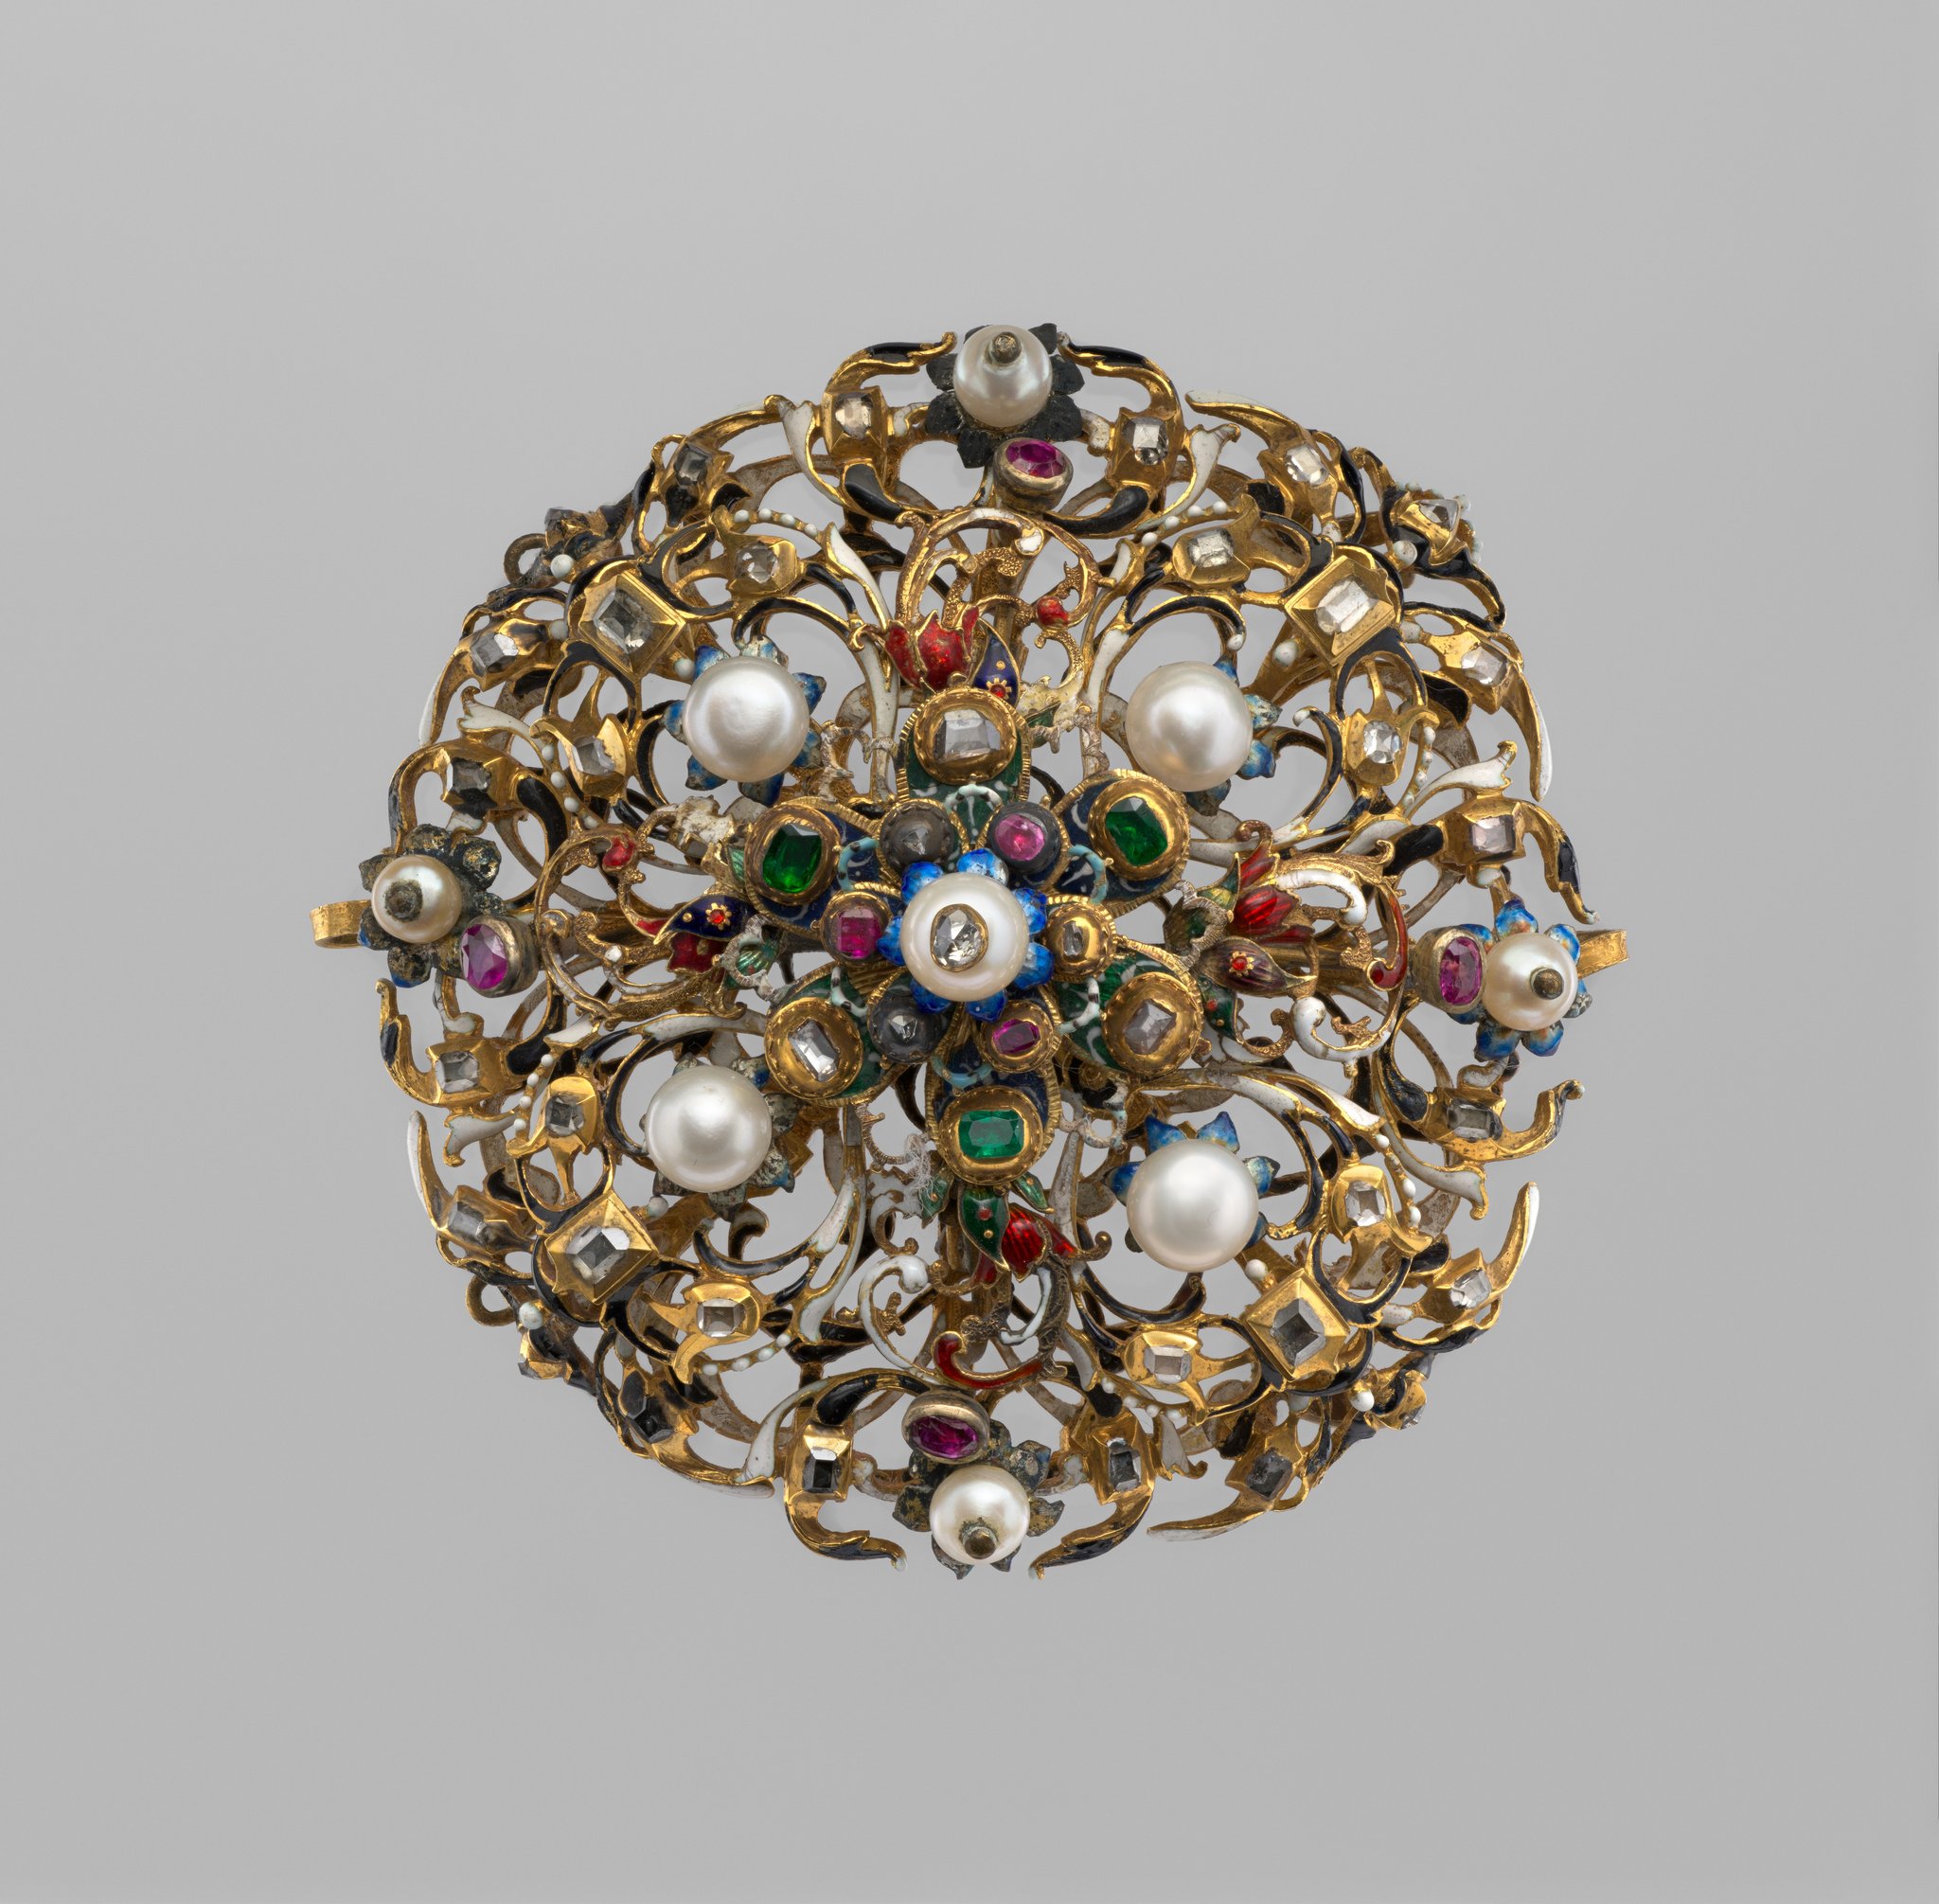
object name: rosette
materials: diamond, gemstone, gold, pearl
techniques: enamel